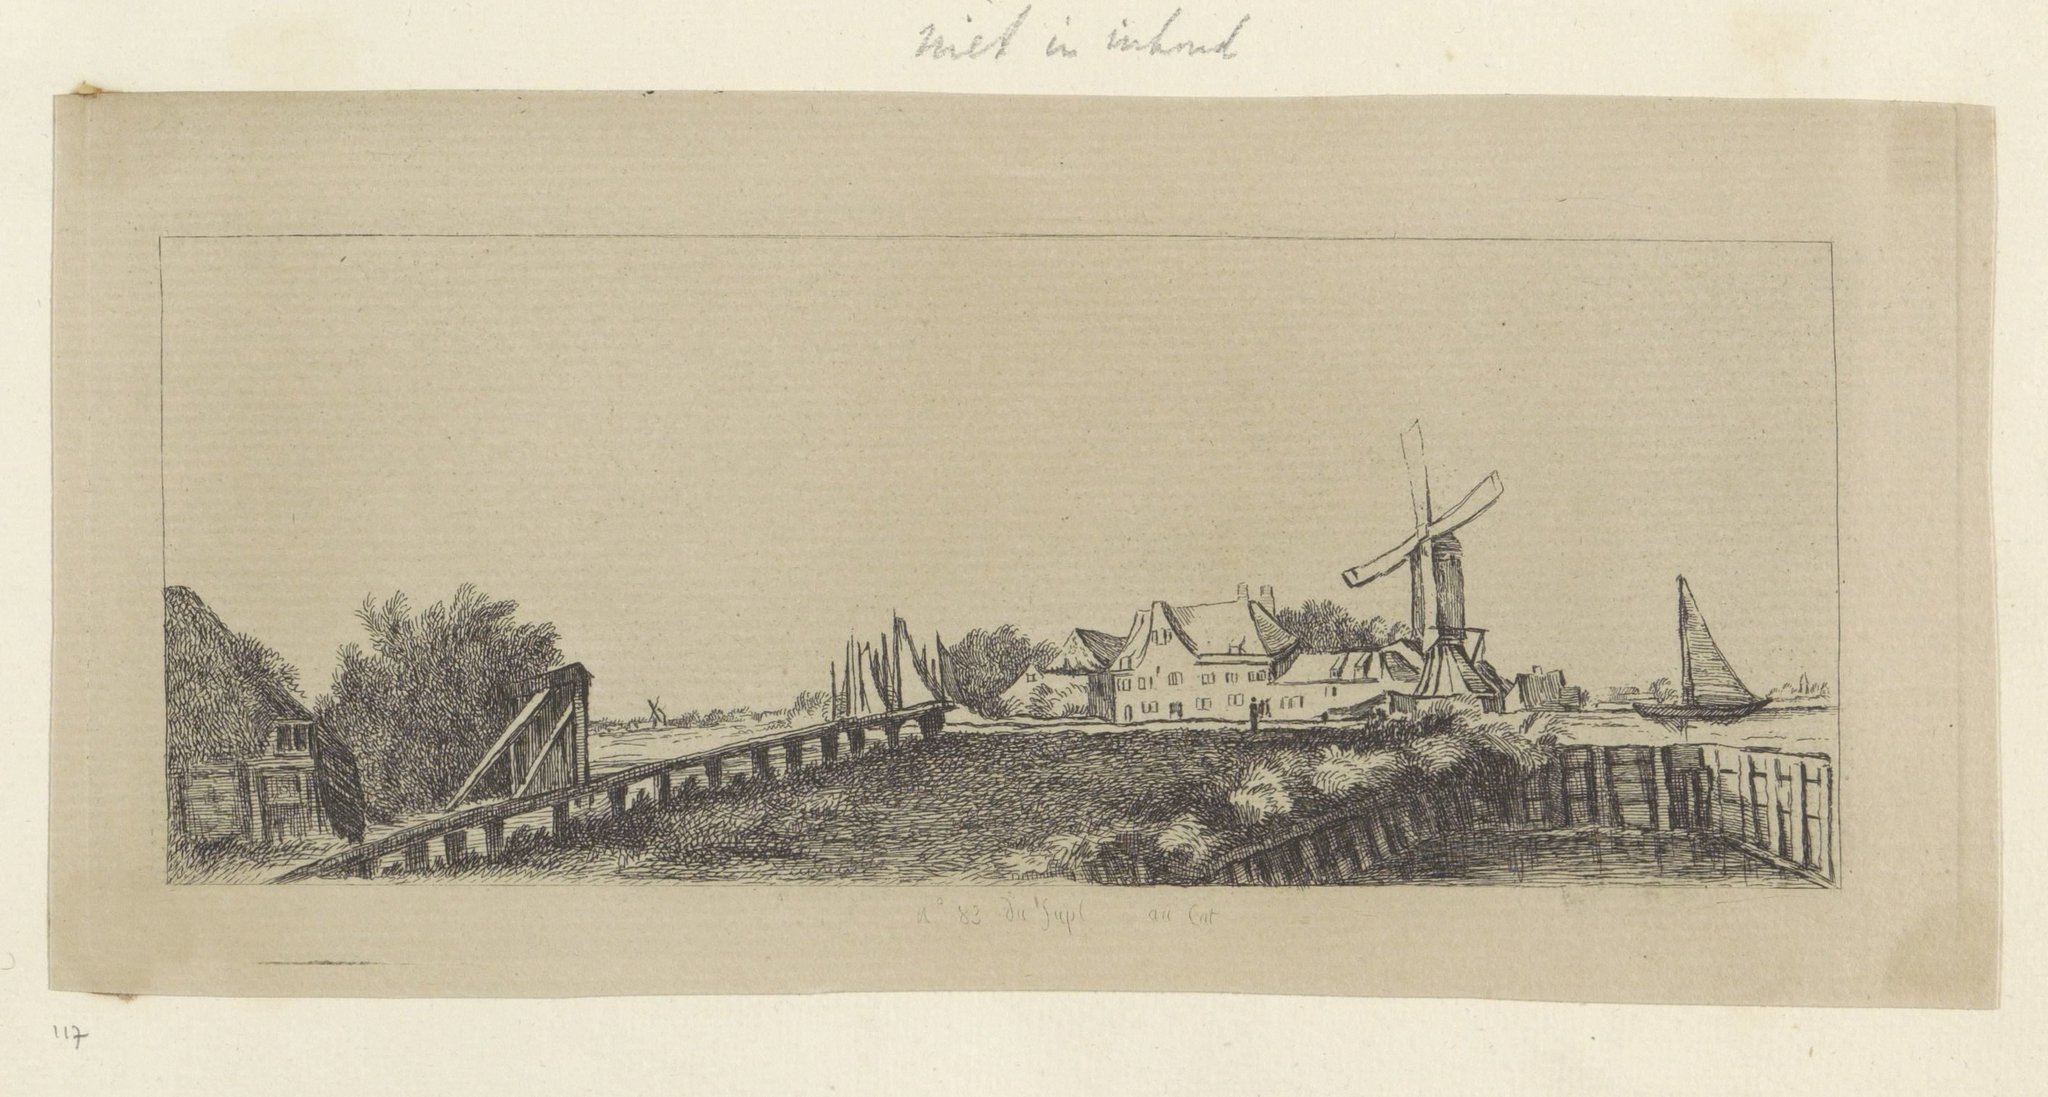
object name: album leaf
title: Landschap met een houten brug en molen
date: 1750-1797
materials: paper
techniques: etching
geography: paris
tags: farm or solitary house in landscape